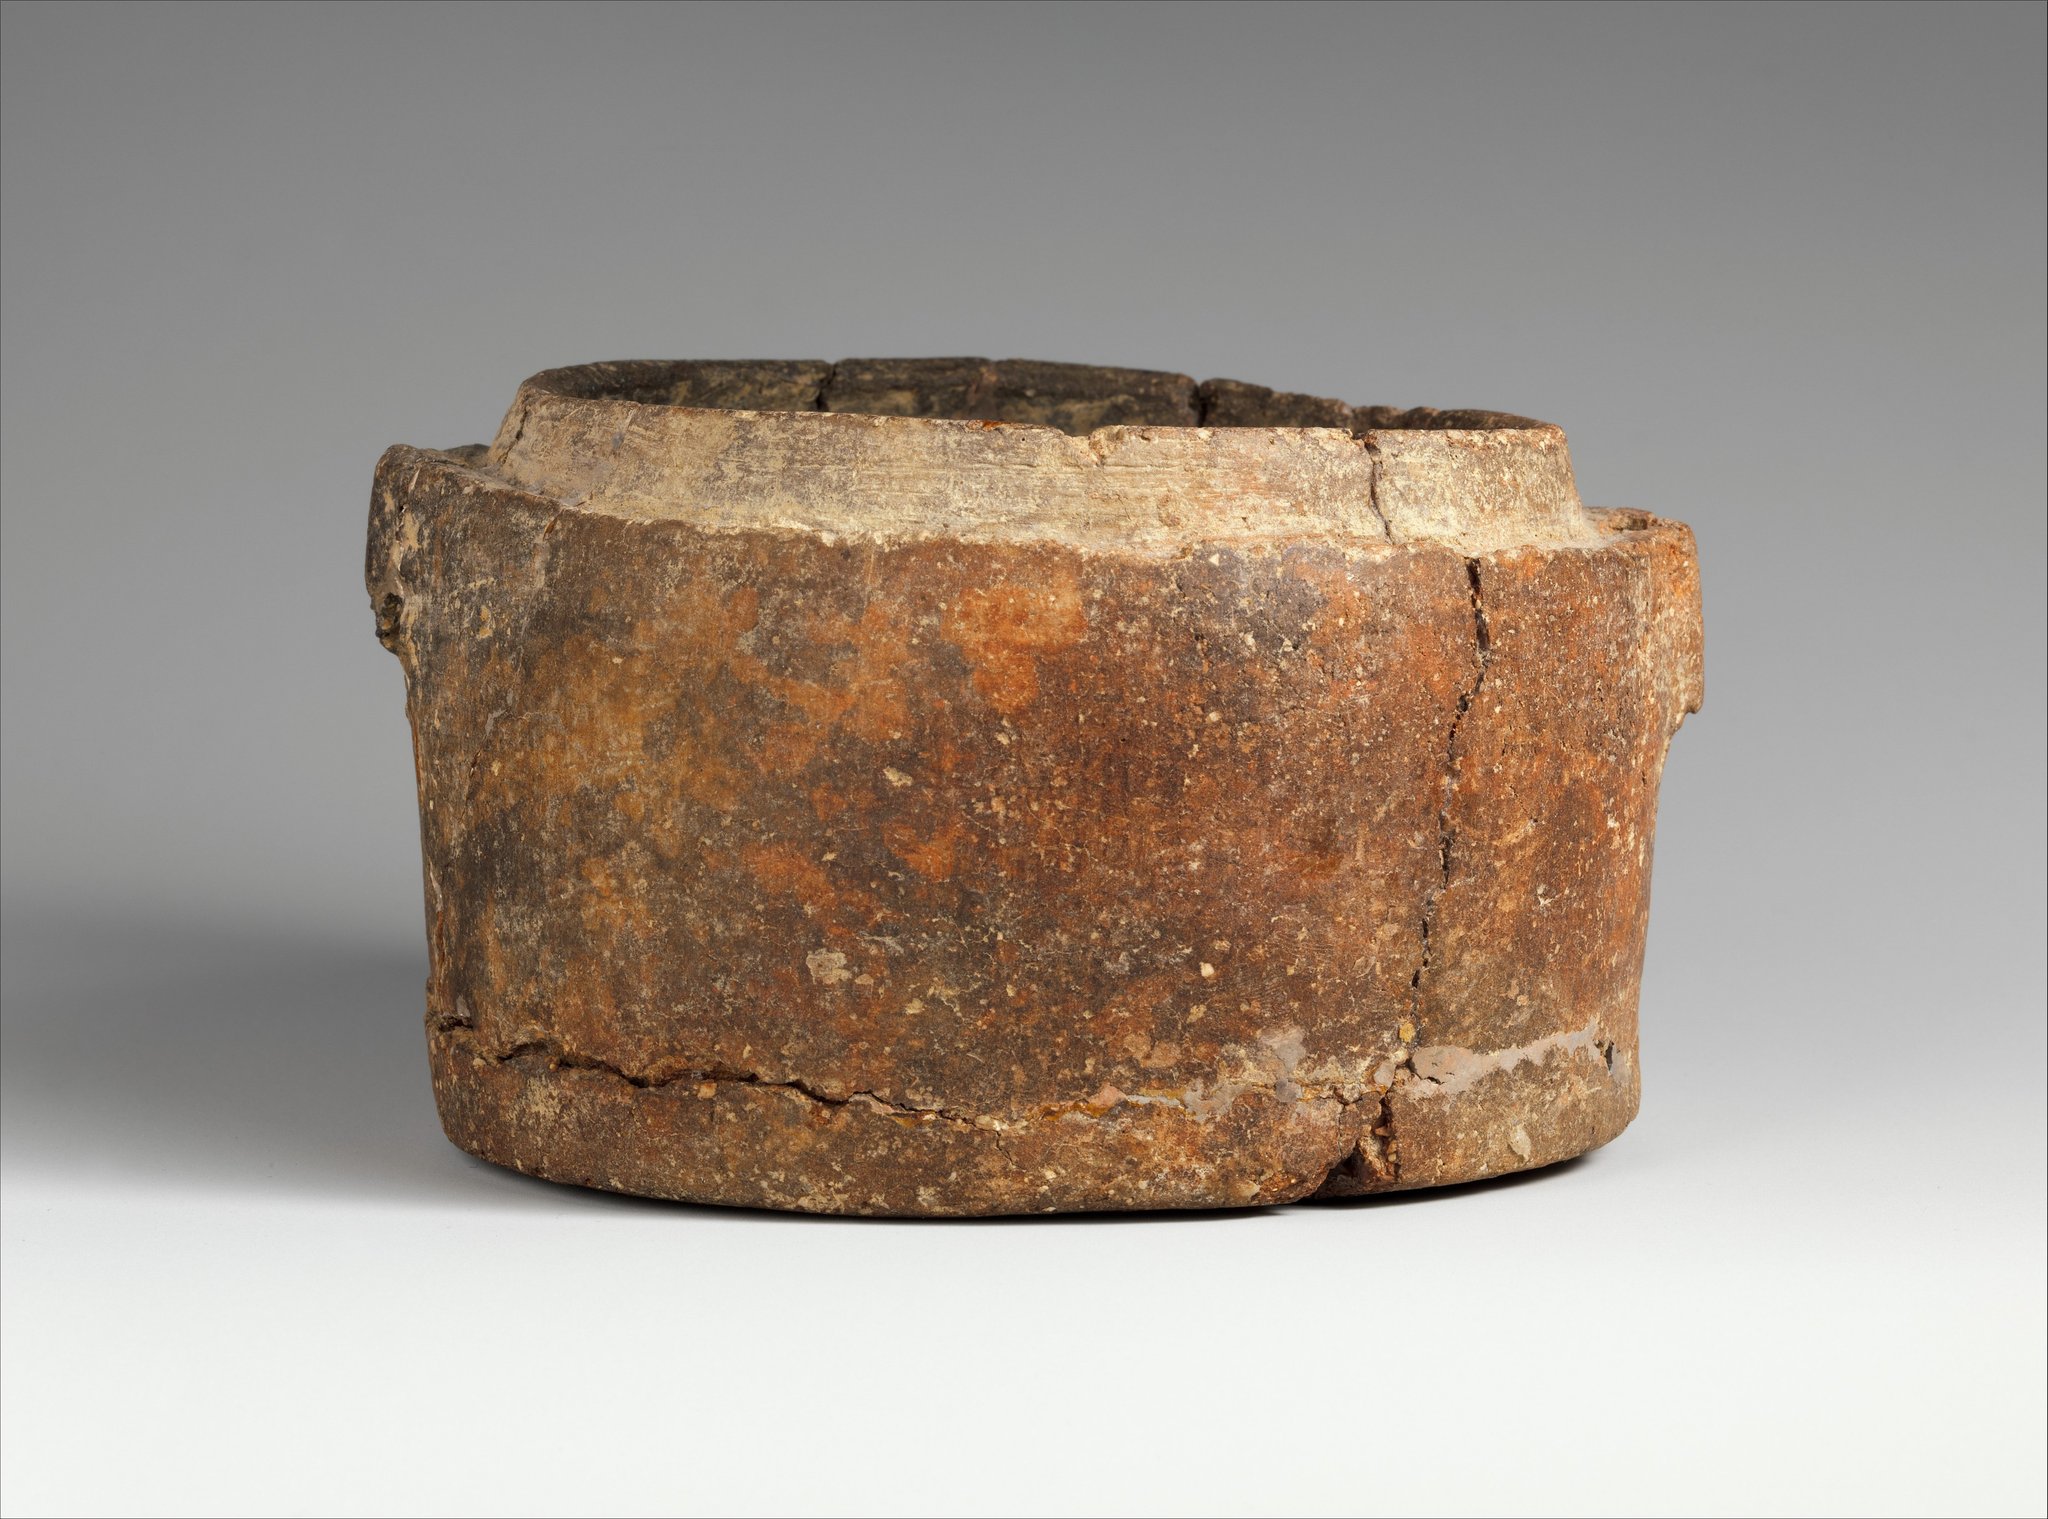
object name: box of a pyxis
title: Terracotta box of a pyxis (small box)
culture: cycladic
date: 3000-2800 BCE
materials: terracotta